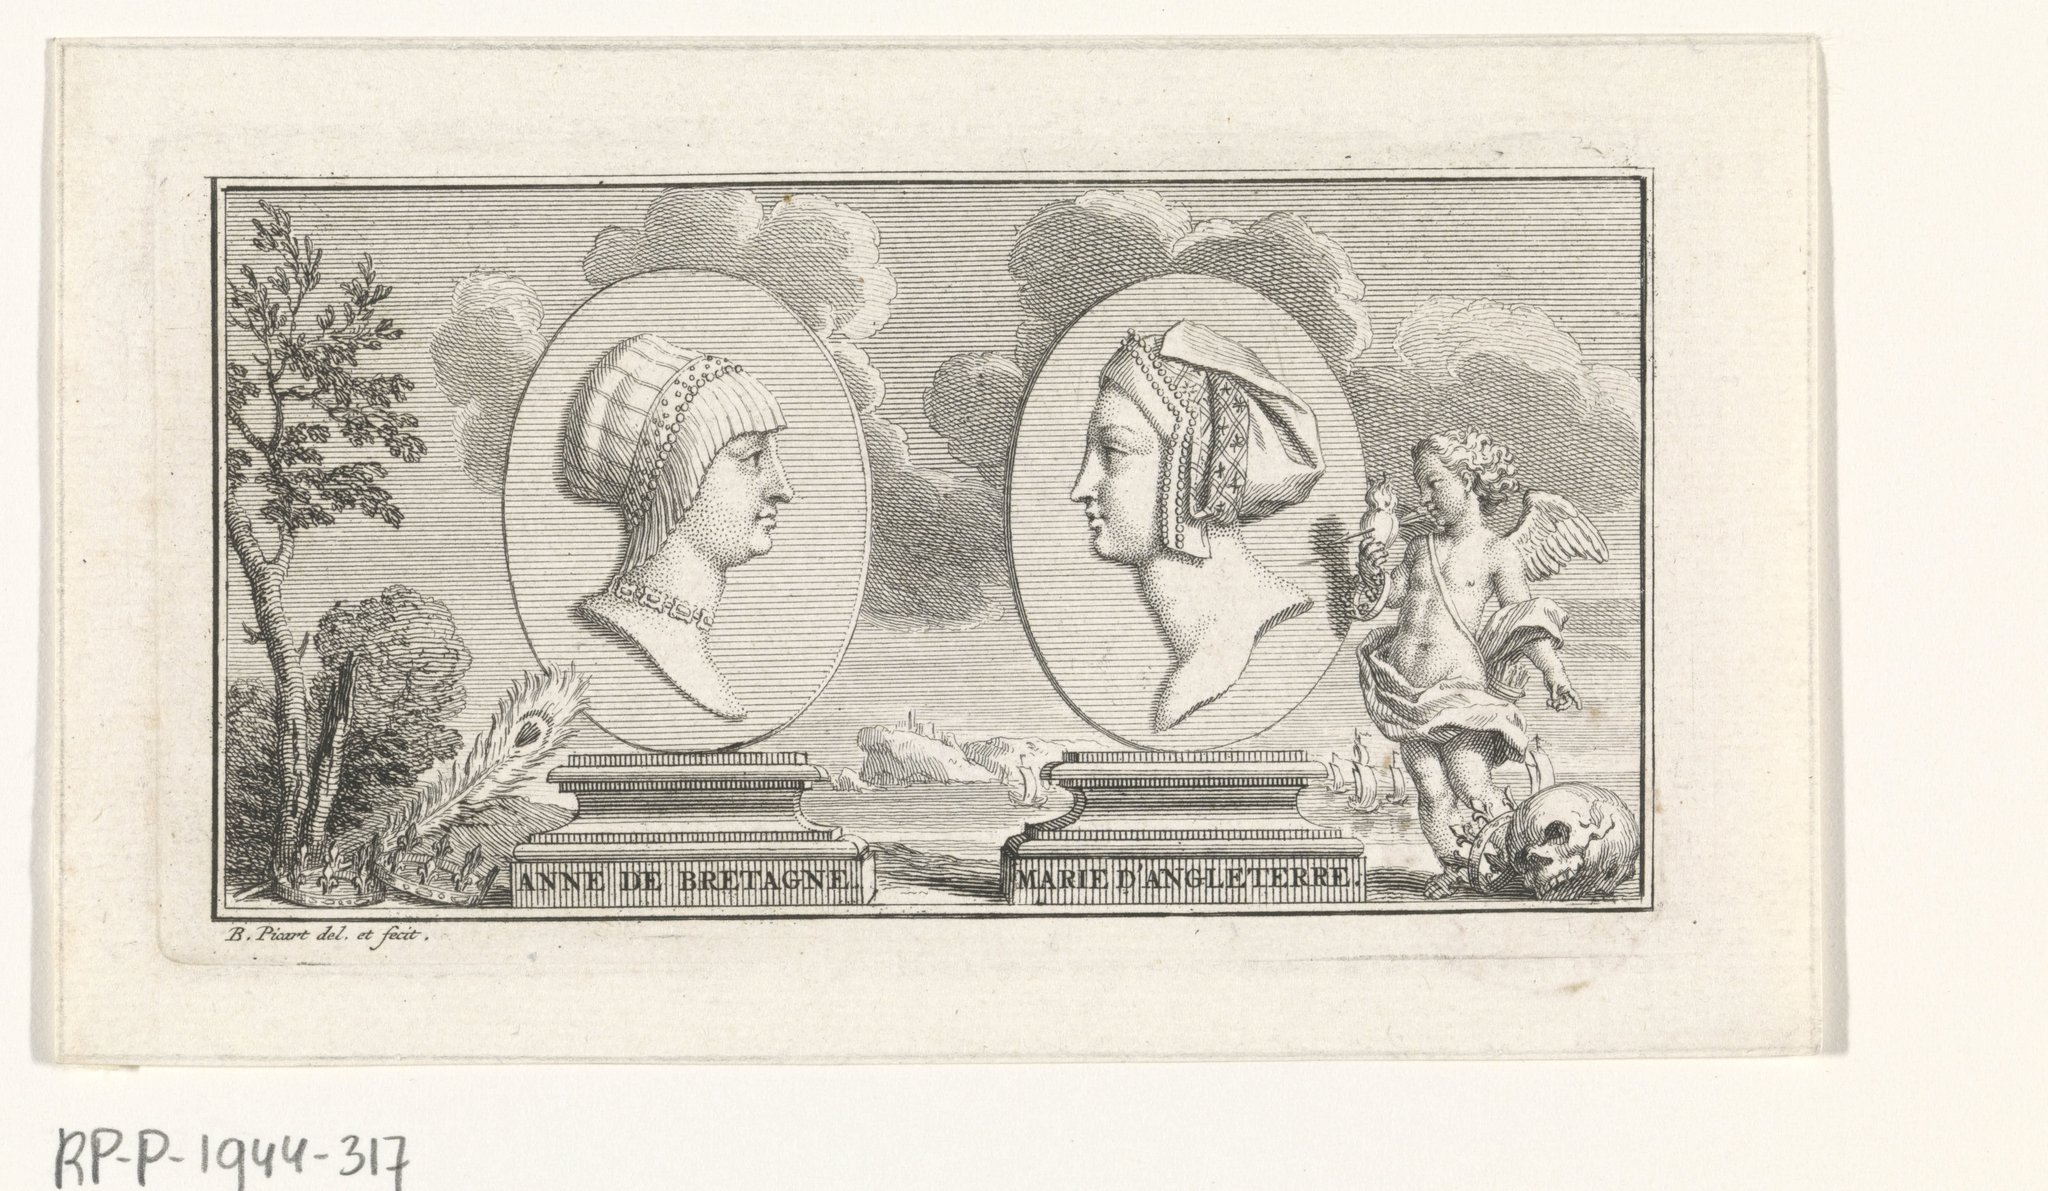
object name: print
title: Portretten van Anna van Bretagne en Maria Tudor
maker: bernard picart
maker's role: draughtsman, print maker, publisher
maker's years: 1673-1733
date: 1683-1733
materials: paper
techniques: engraving, etching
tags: crown (symbol of sovereignty), memorial medal, 'vanitas' symbols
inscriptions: collector's mark: Lugt 240, collector's mark: Lugt 2228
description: Medaillons met de portretten van Anna van Bretagne en Maria Tudor, die elkaar opvolgden als koningin van Frankrijk. Op de voorgrond kronen en een putto die naar een schedel wijst.